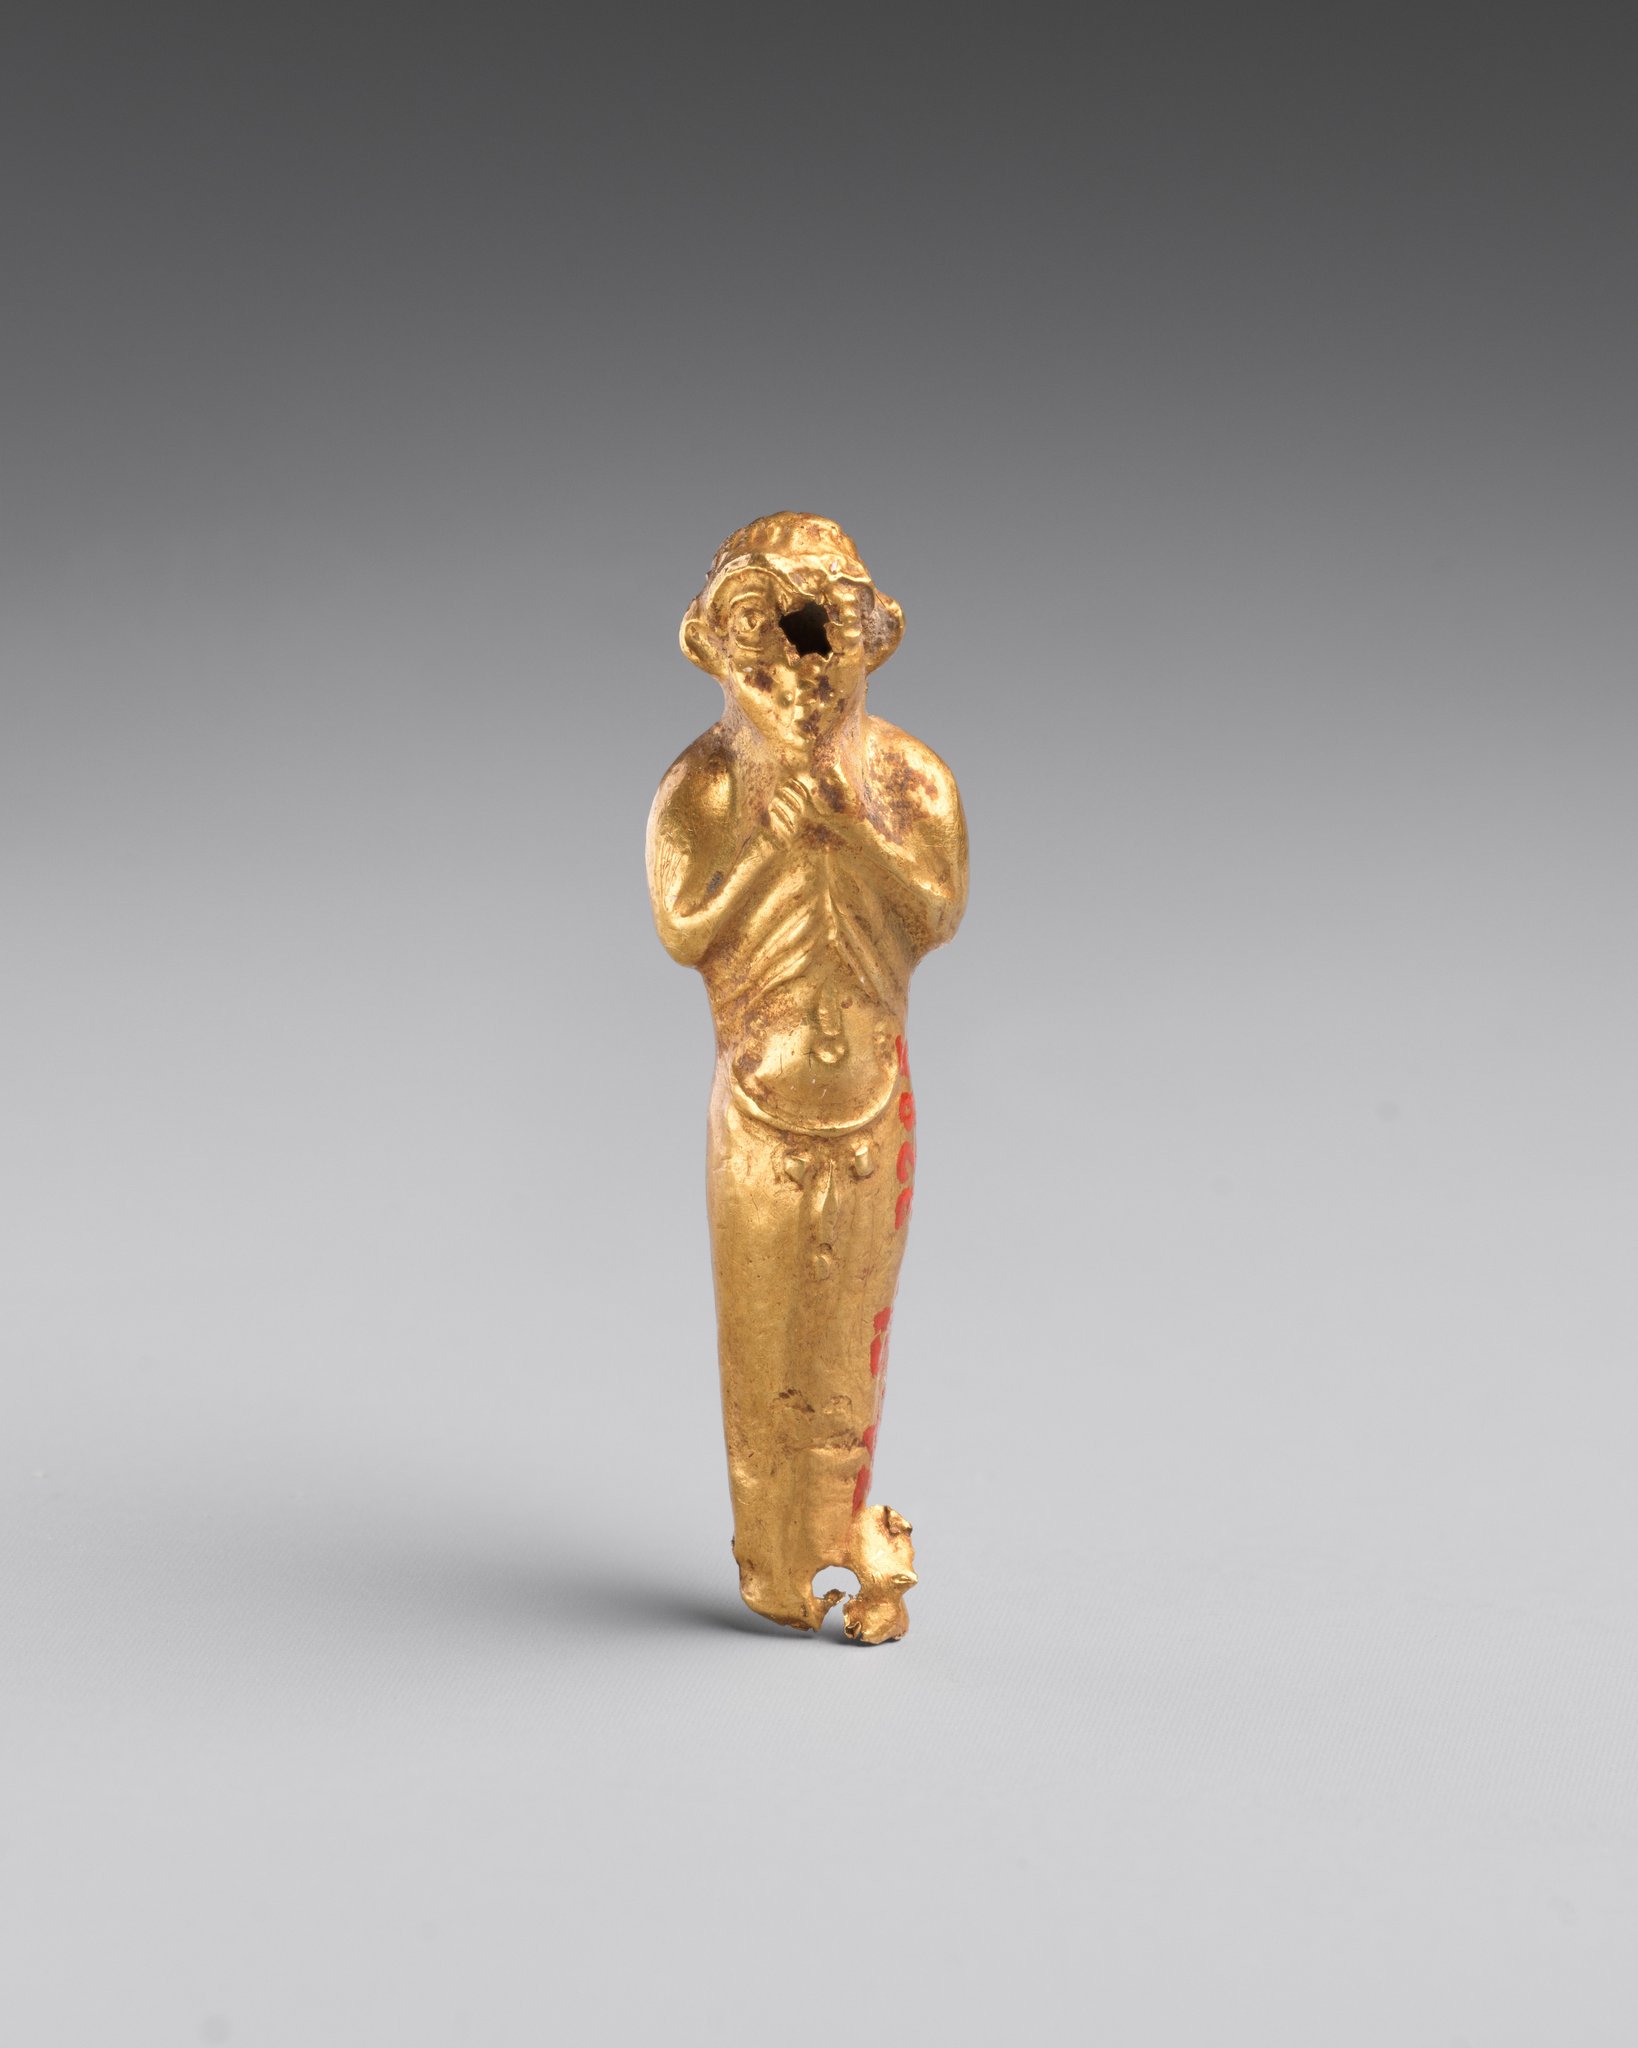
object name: pendant in the form of a goddess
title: Gold amulet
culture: cypro-phoenician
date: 600-301 BCE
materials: gold